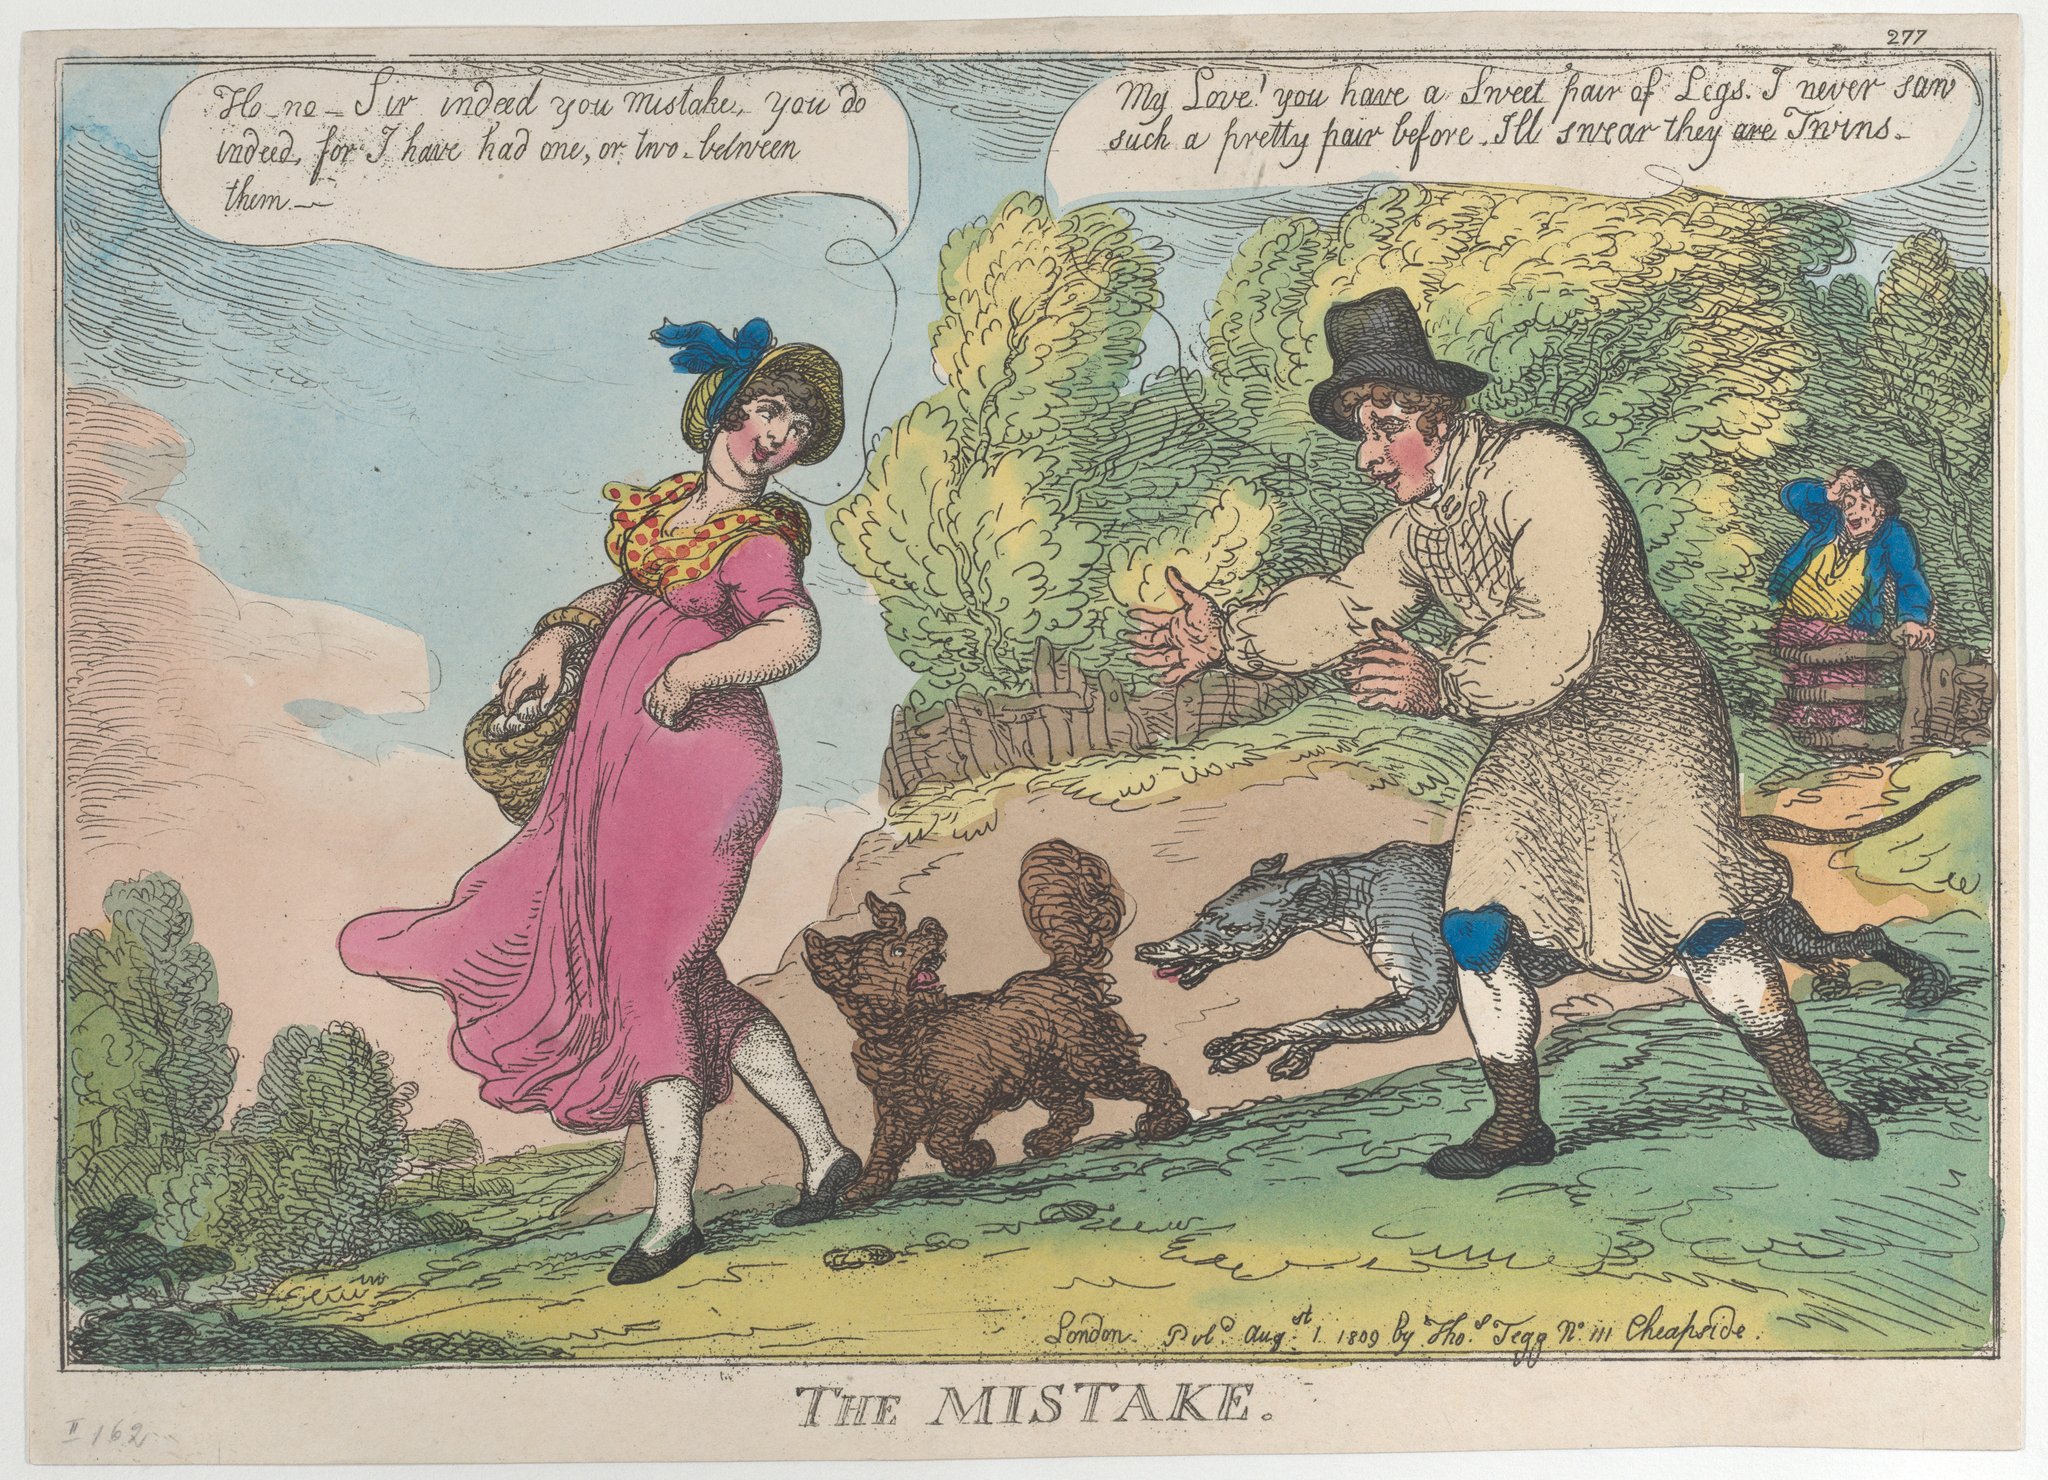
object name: print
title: The Mistake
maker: thomas rowlandson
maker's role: artist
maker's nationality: british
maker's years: 1757-1827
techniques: etching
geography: london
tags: satire,men,women,dogs